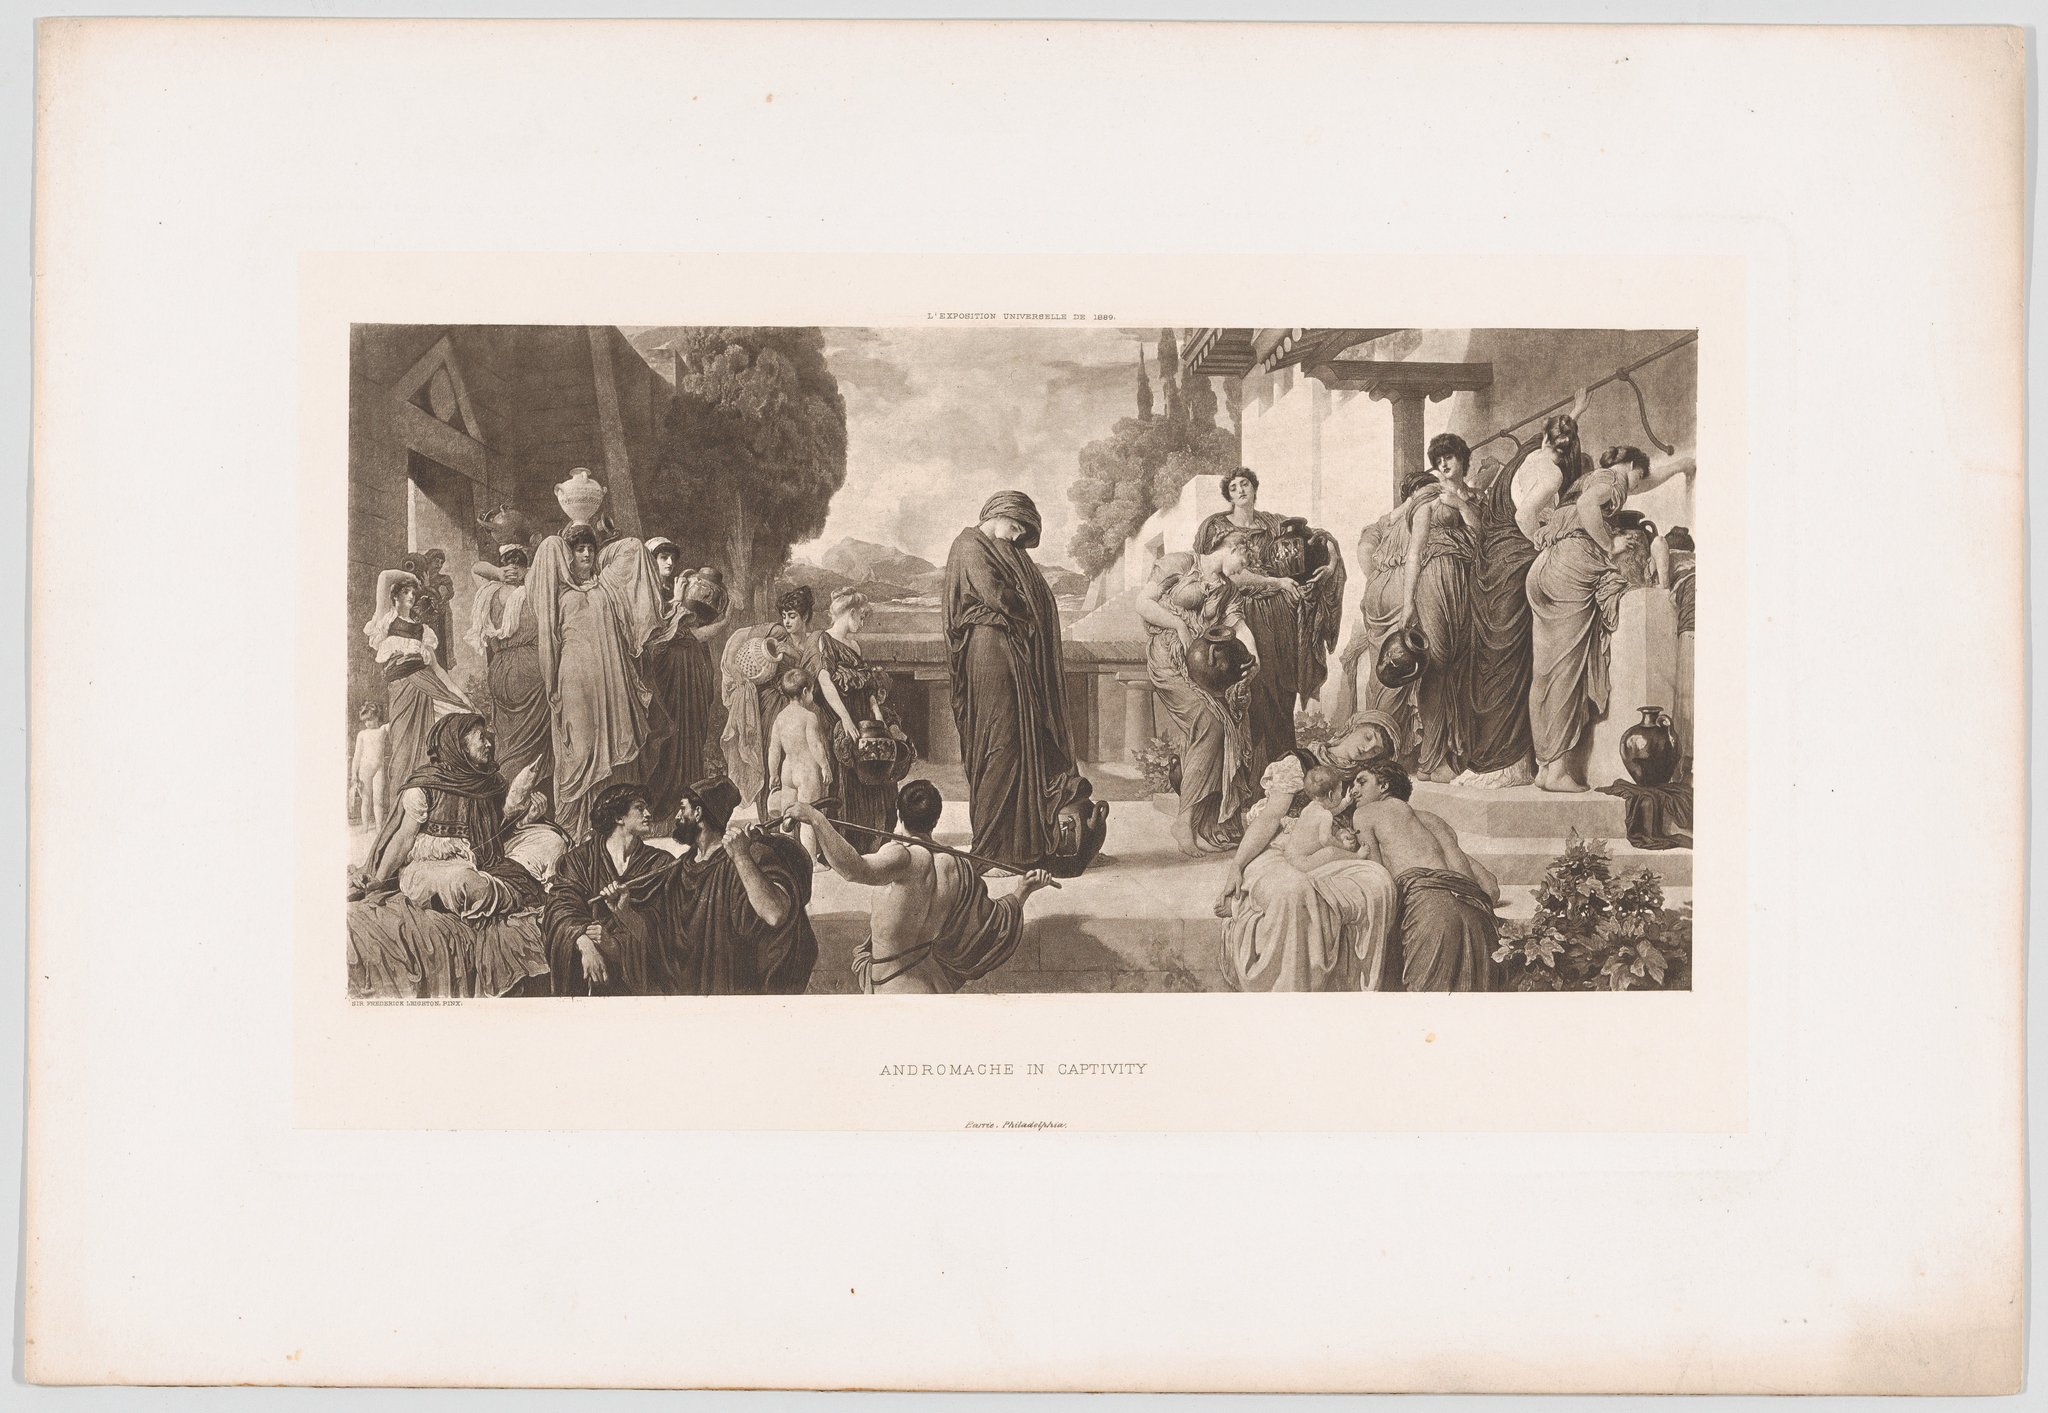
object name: print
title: Andromache in Captivity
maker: frederic, lord leighton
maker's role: artist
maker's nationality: british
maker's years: 1830-1896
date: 1889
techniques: printmaking, photogravure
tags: children,men,women,andromache